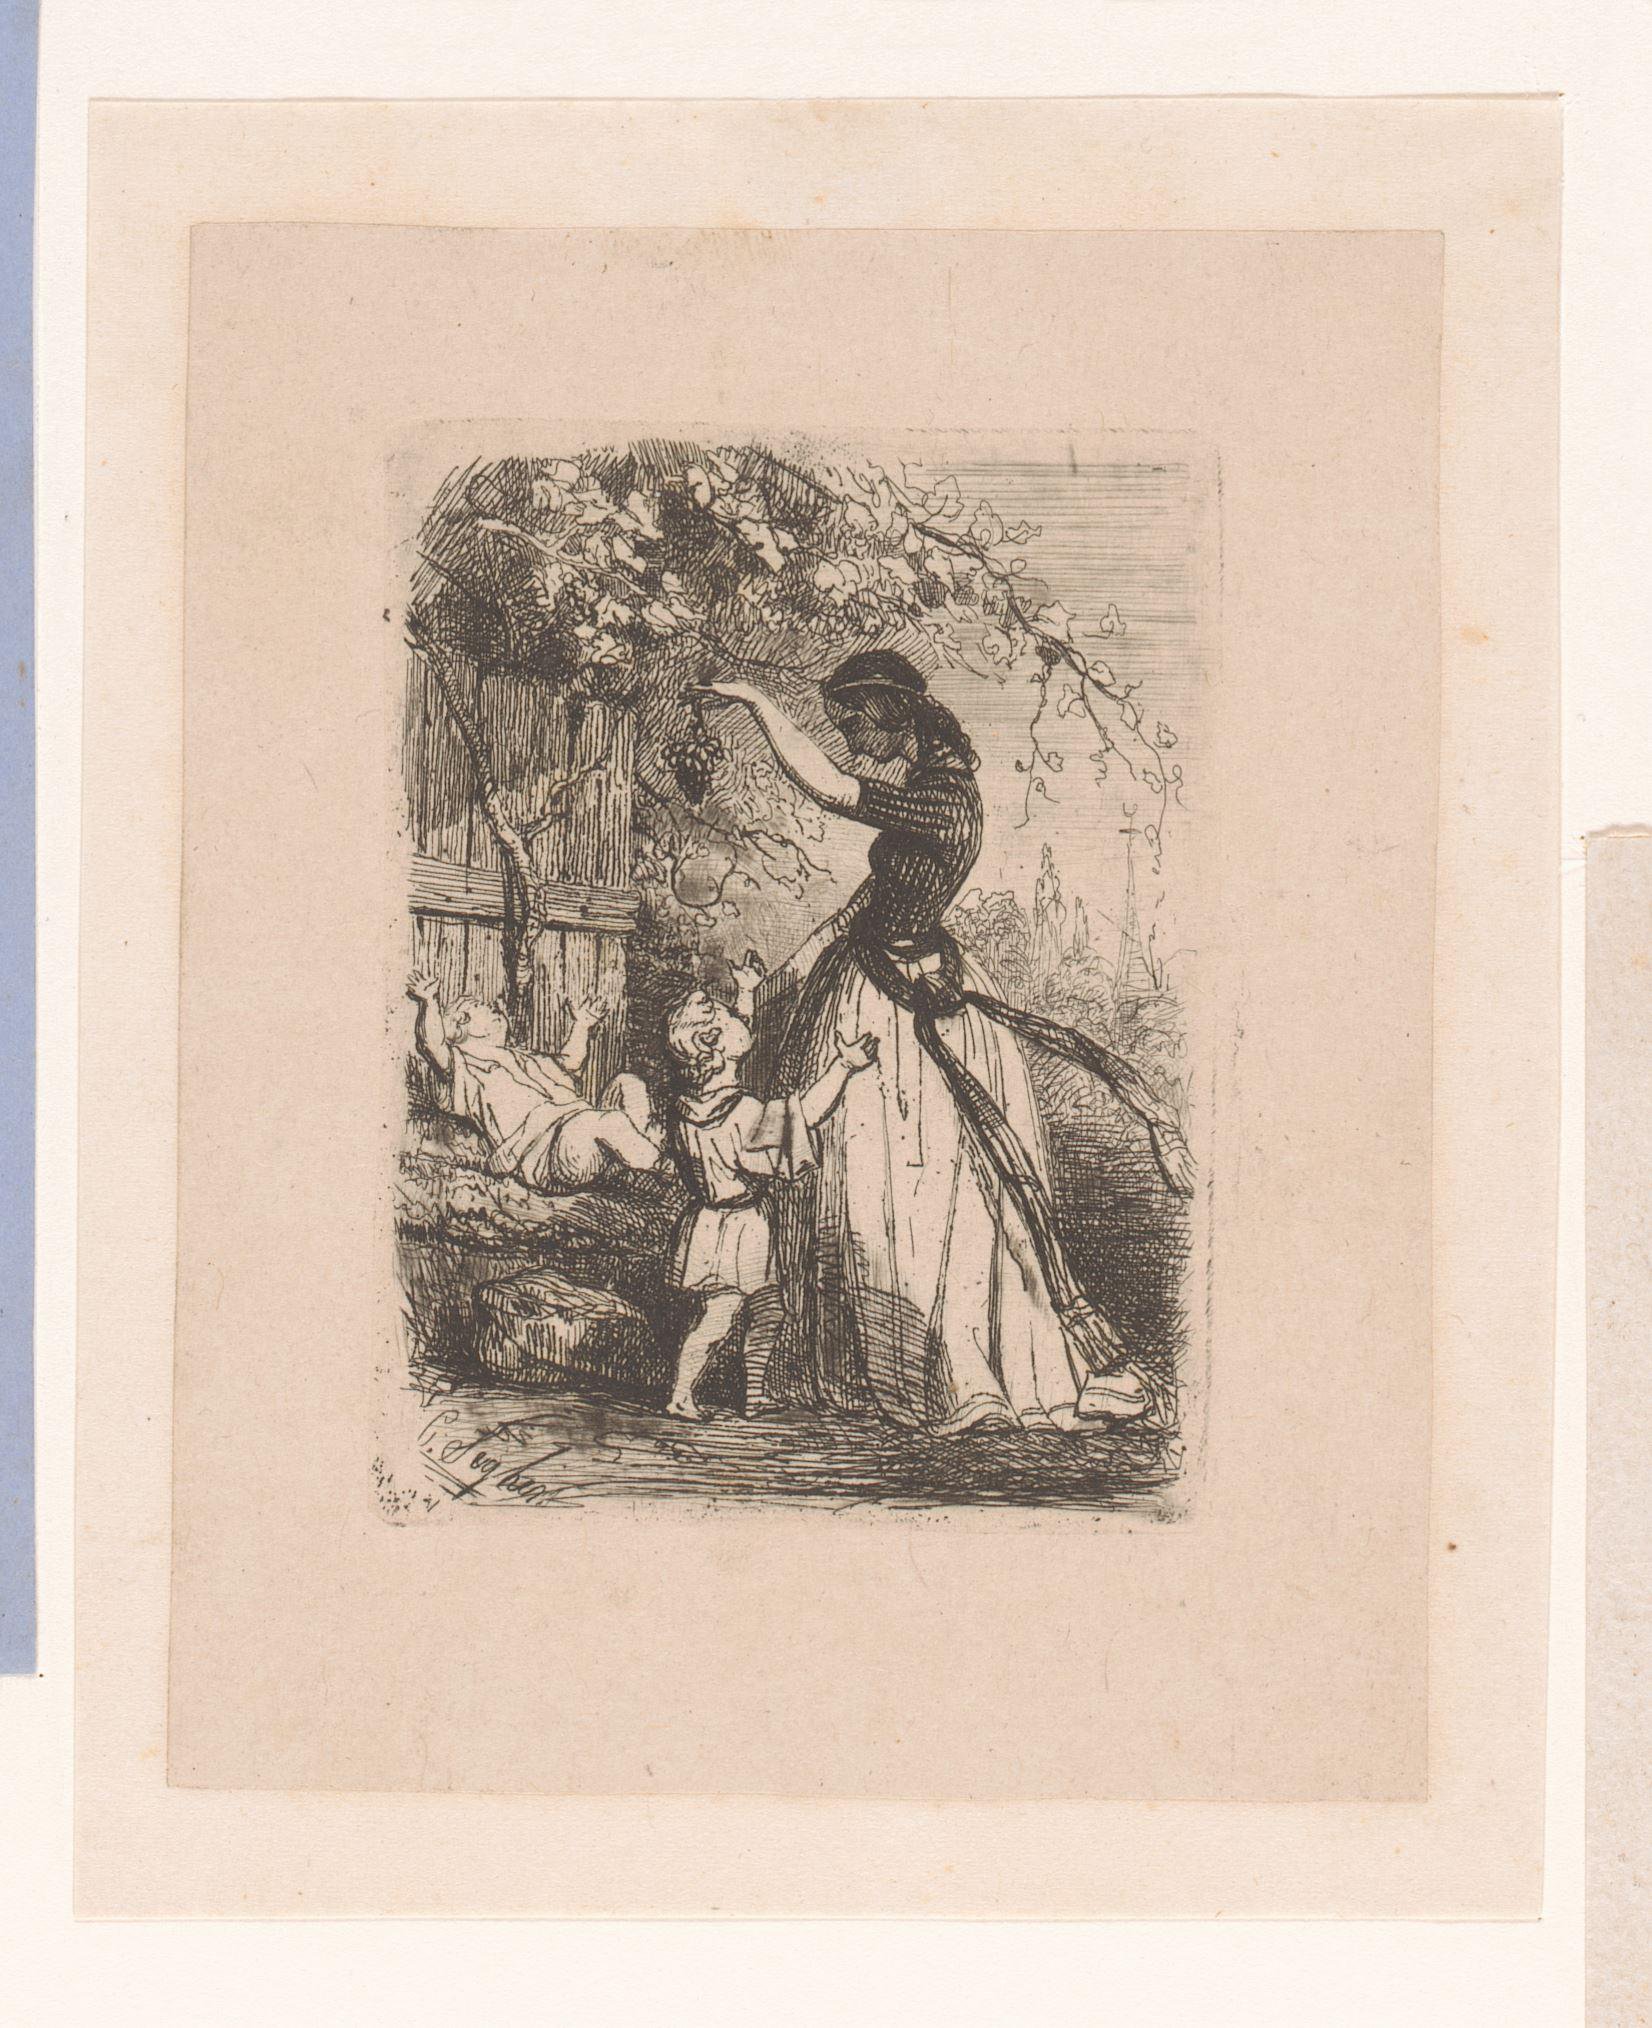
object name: print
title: Moeder houdt een tros druiven hoog boven haar kind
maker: corneille seghers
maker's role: draughtsman, print maker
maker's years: 1814-1869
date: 1824-1869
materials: paper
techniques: drypoint, etching, intaglio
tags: mother and son(s) (family group), bunch of grapes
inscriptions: collector's mark: Lugt 1485, collector's mark: Lugt 2228